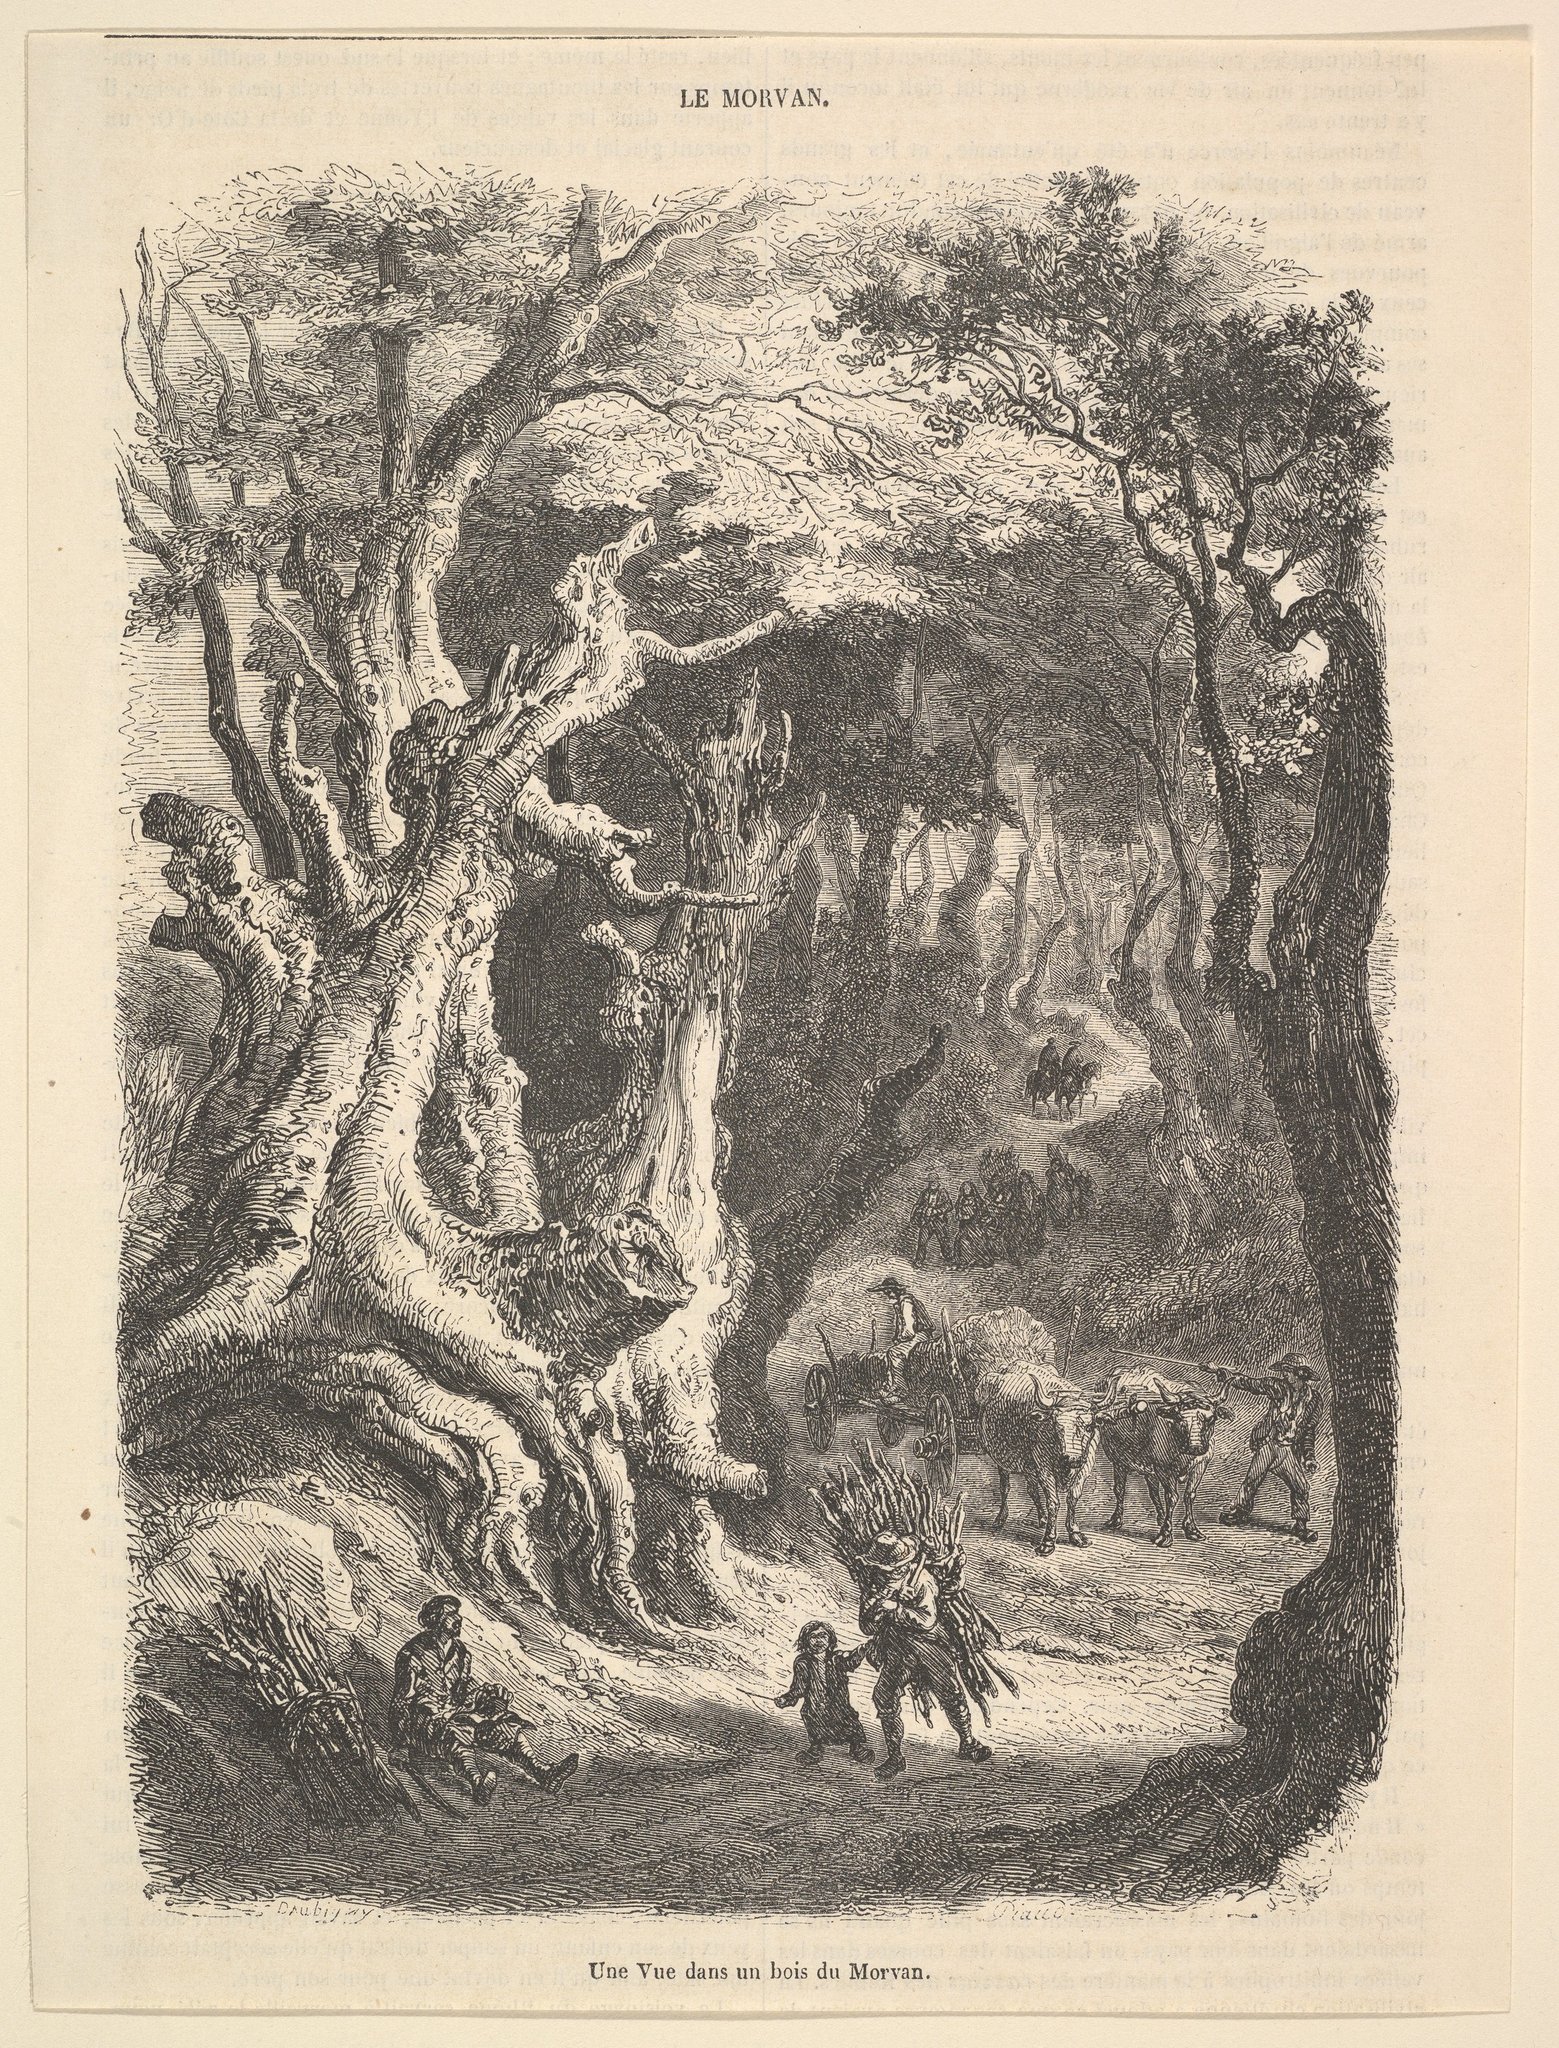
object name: print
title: A View in the Forest of Morvan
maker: antoine-alphée piaud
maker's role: artist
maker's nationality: french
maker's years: 1813-1867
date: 1837-1866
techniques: engraving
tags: animals,men,forests,trees,carriages